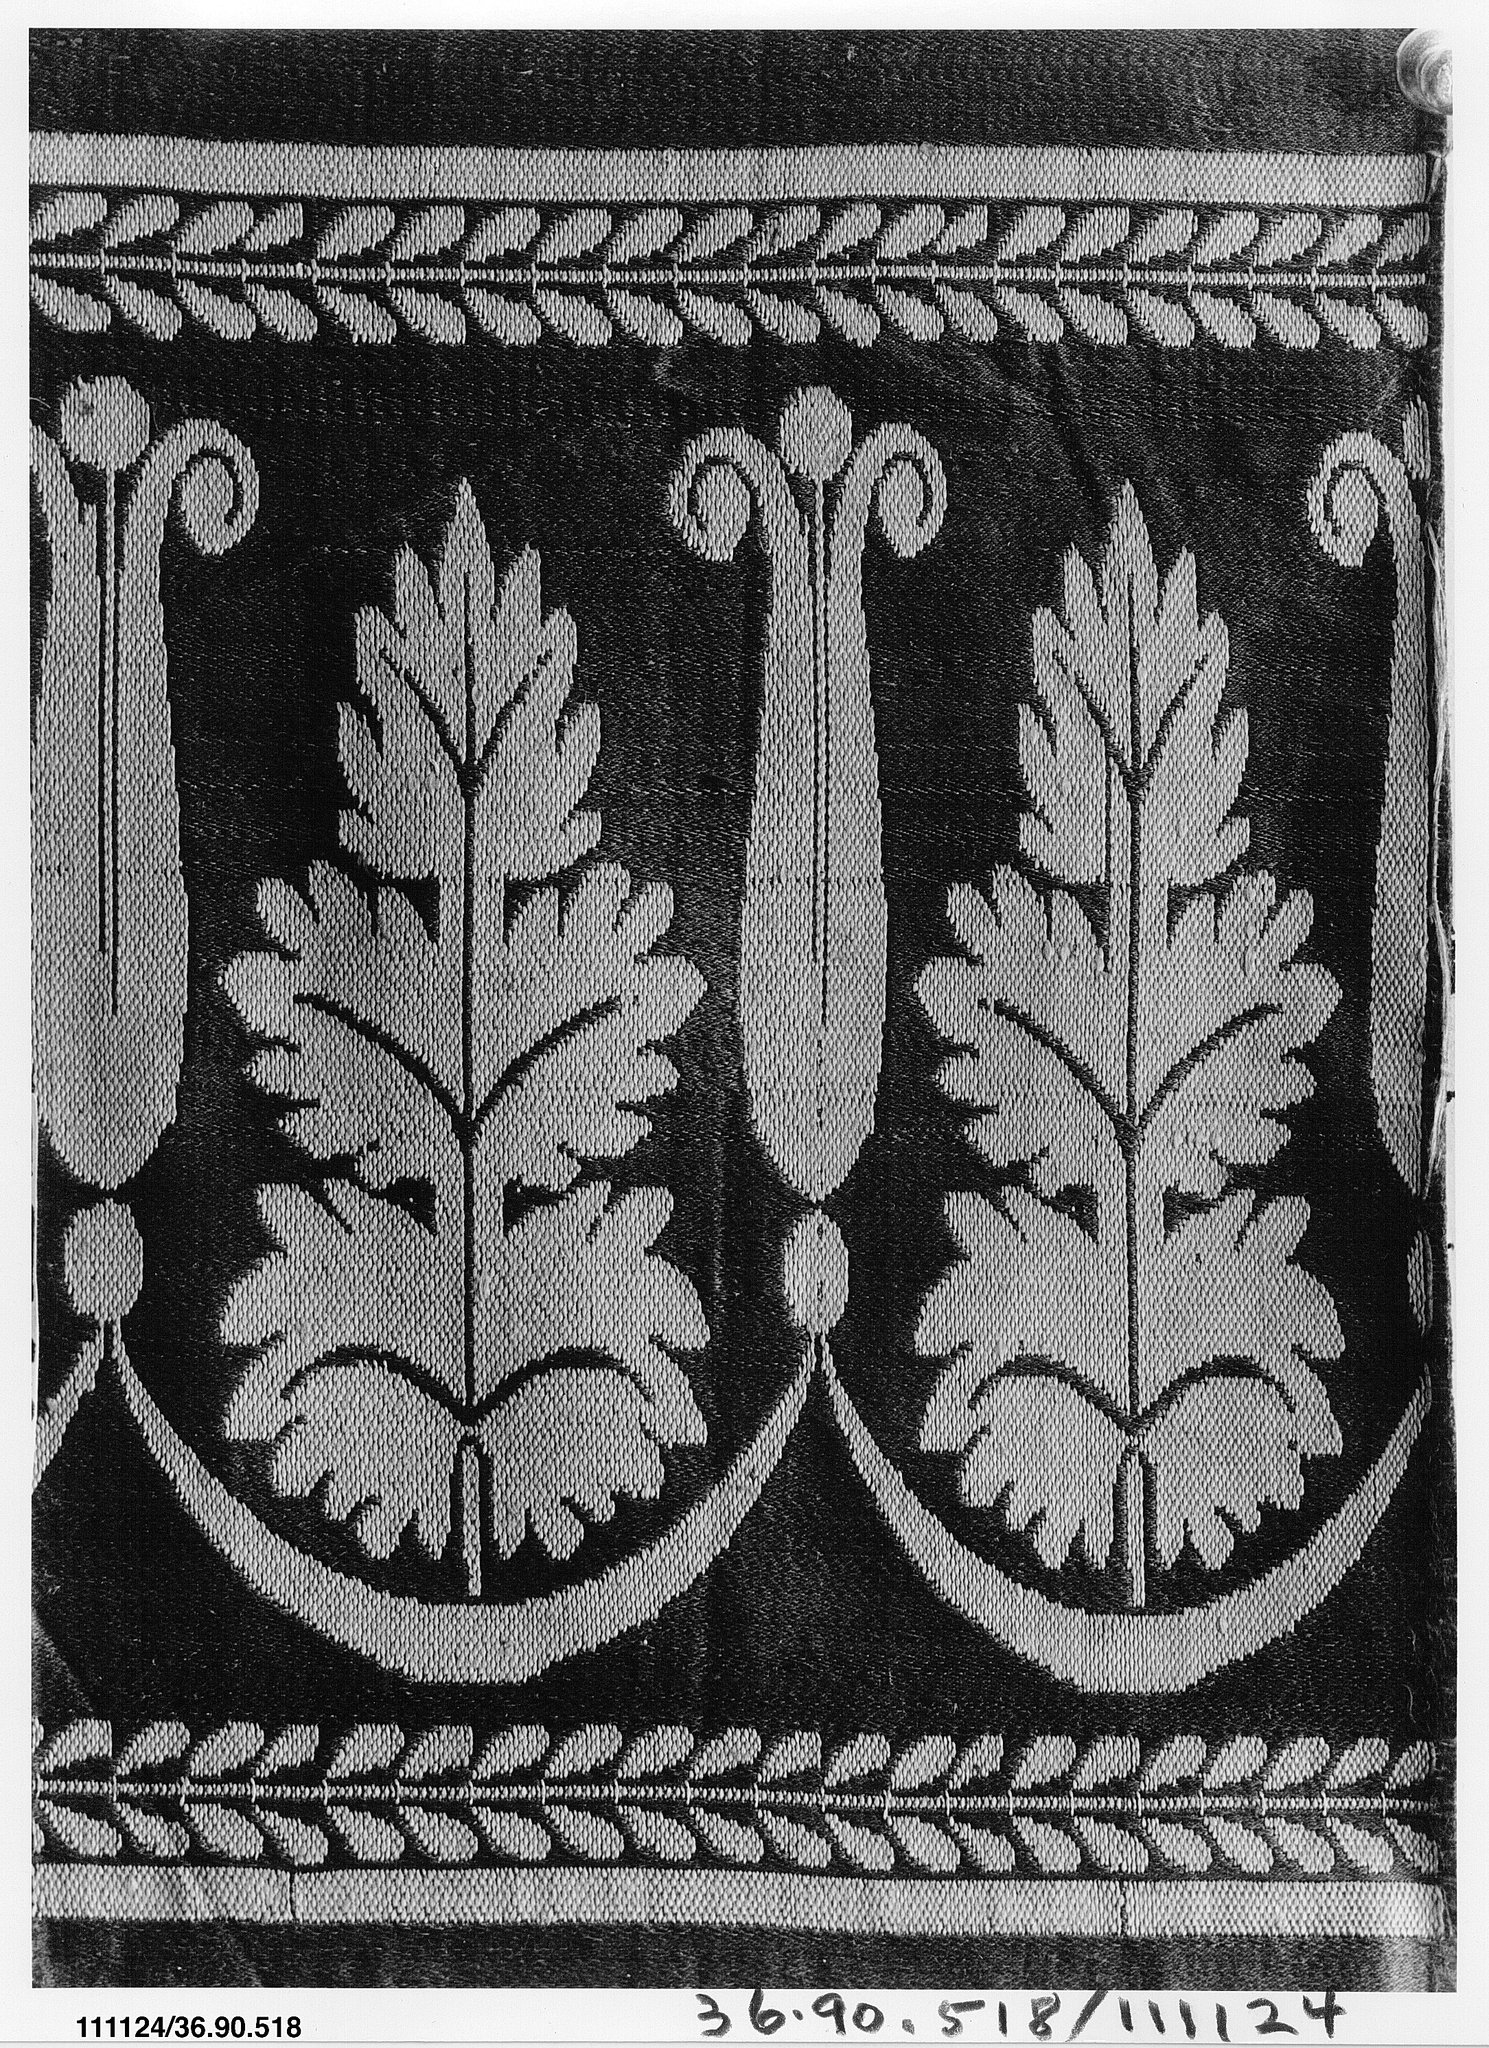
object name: piece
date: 1801-1833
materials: silk